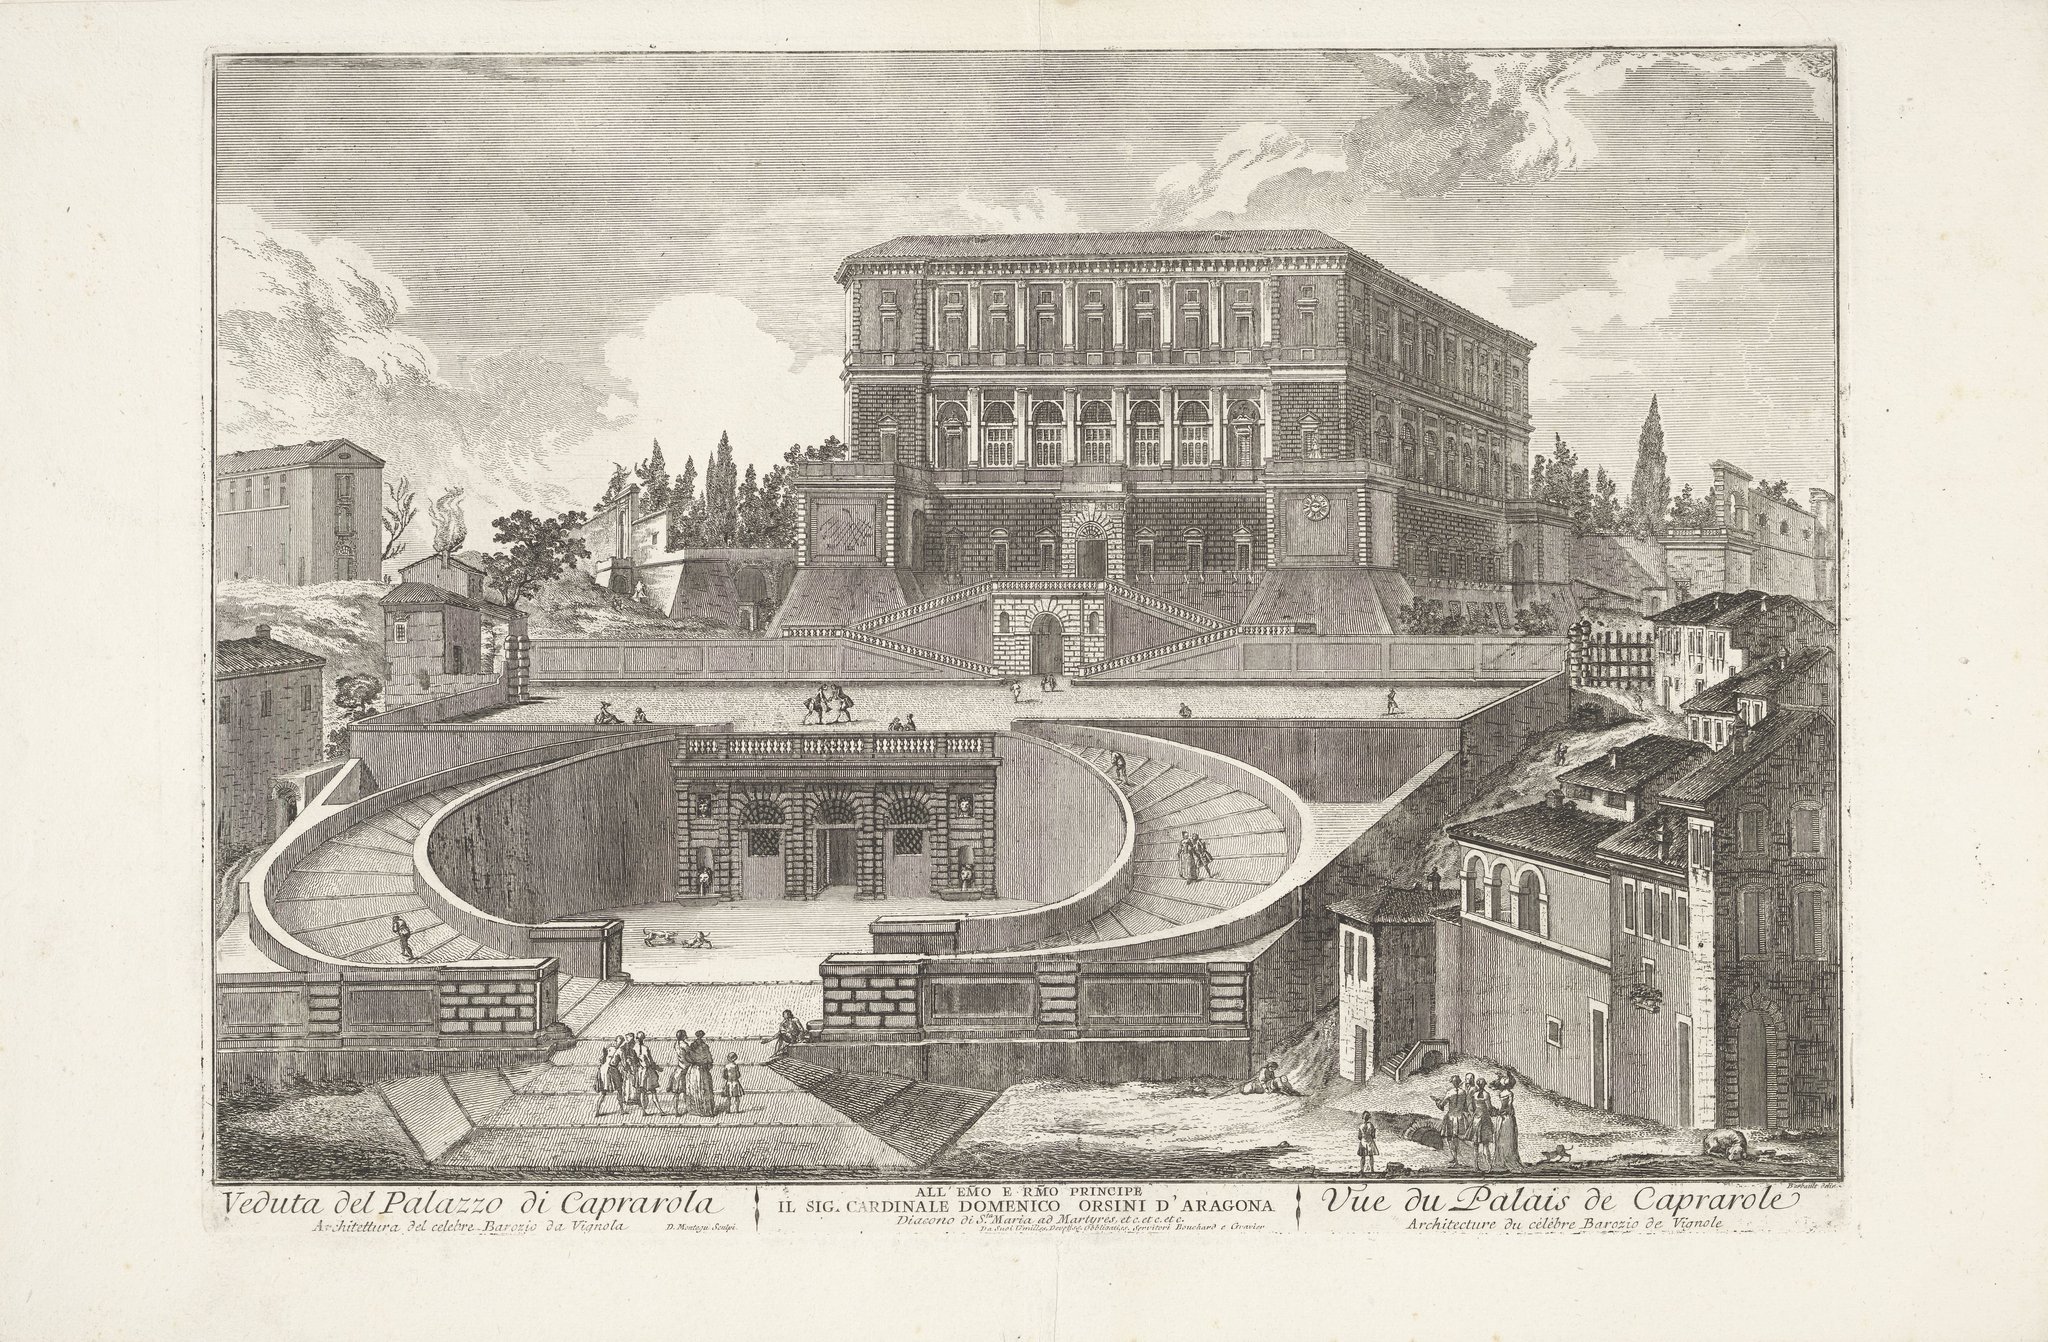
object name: print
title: Villa Farnese te Caprarola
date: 1750-1799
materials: paper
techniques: etching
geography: italy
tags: city-view, and landscape with man-made constructions, villa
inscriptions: collector's mark: Lugt 2228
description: Gezicht op de Villa Farnese, ook bekend als Palazzo Farnese of Villa Caprarola, een monumentale Italiaanse villa in Caprarola, in de provincie Viterbo. Titels en tekst in het Frans en Italiaans en een opdracht in de ondermarge.